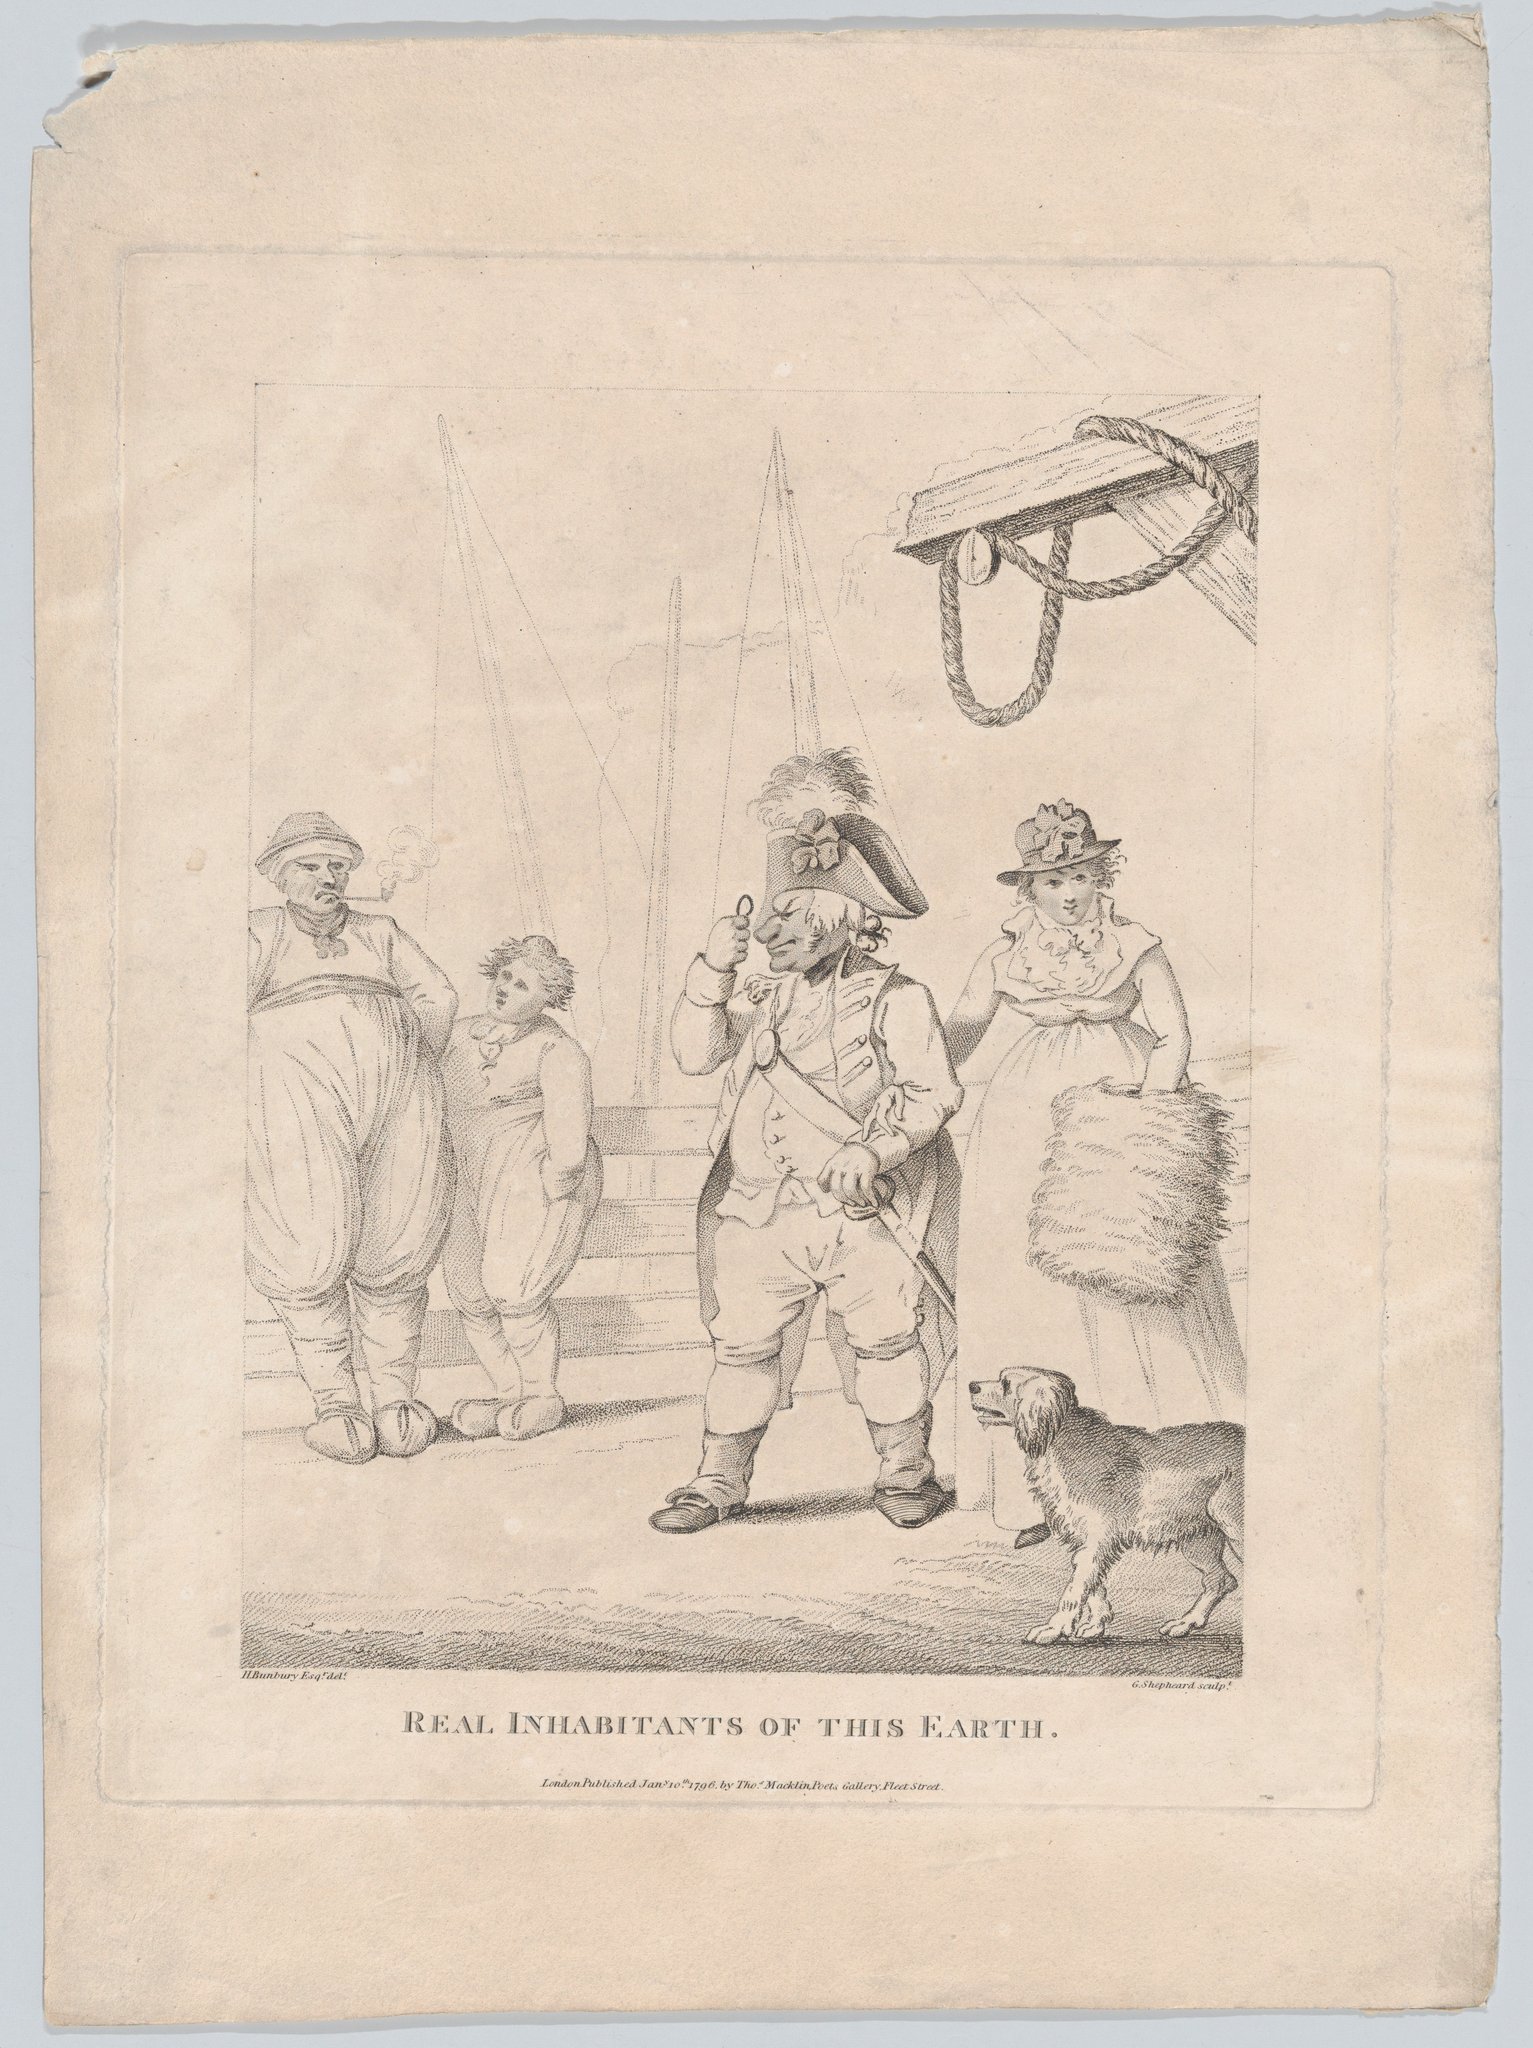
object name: print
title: Real Inhabitants of This Earth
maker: george shepheard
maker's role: etcher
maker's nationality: british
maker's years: 1770-1842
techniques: etching, engraving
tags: satire,men,women,dogs